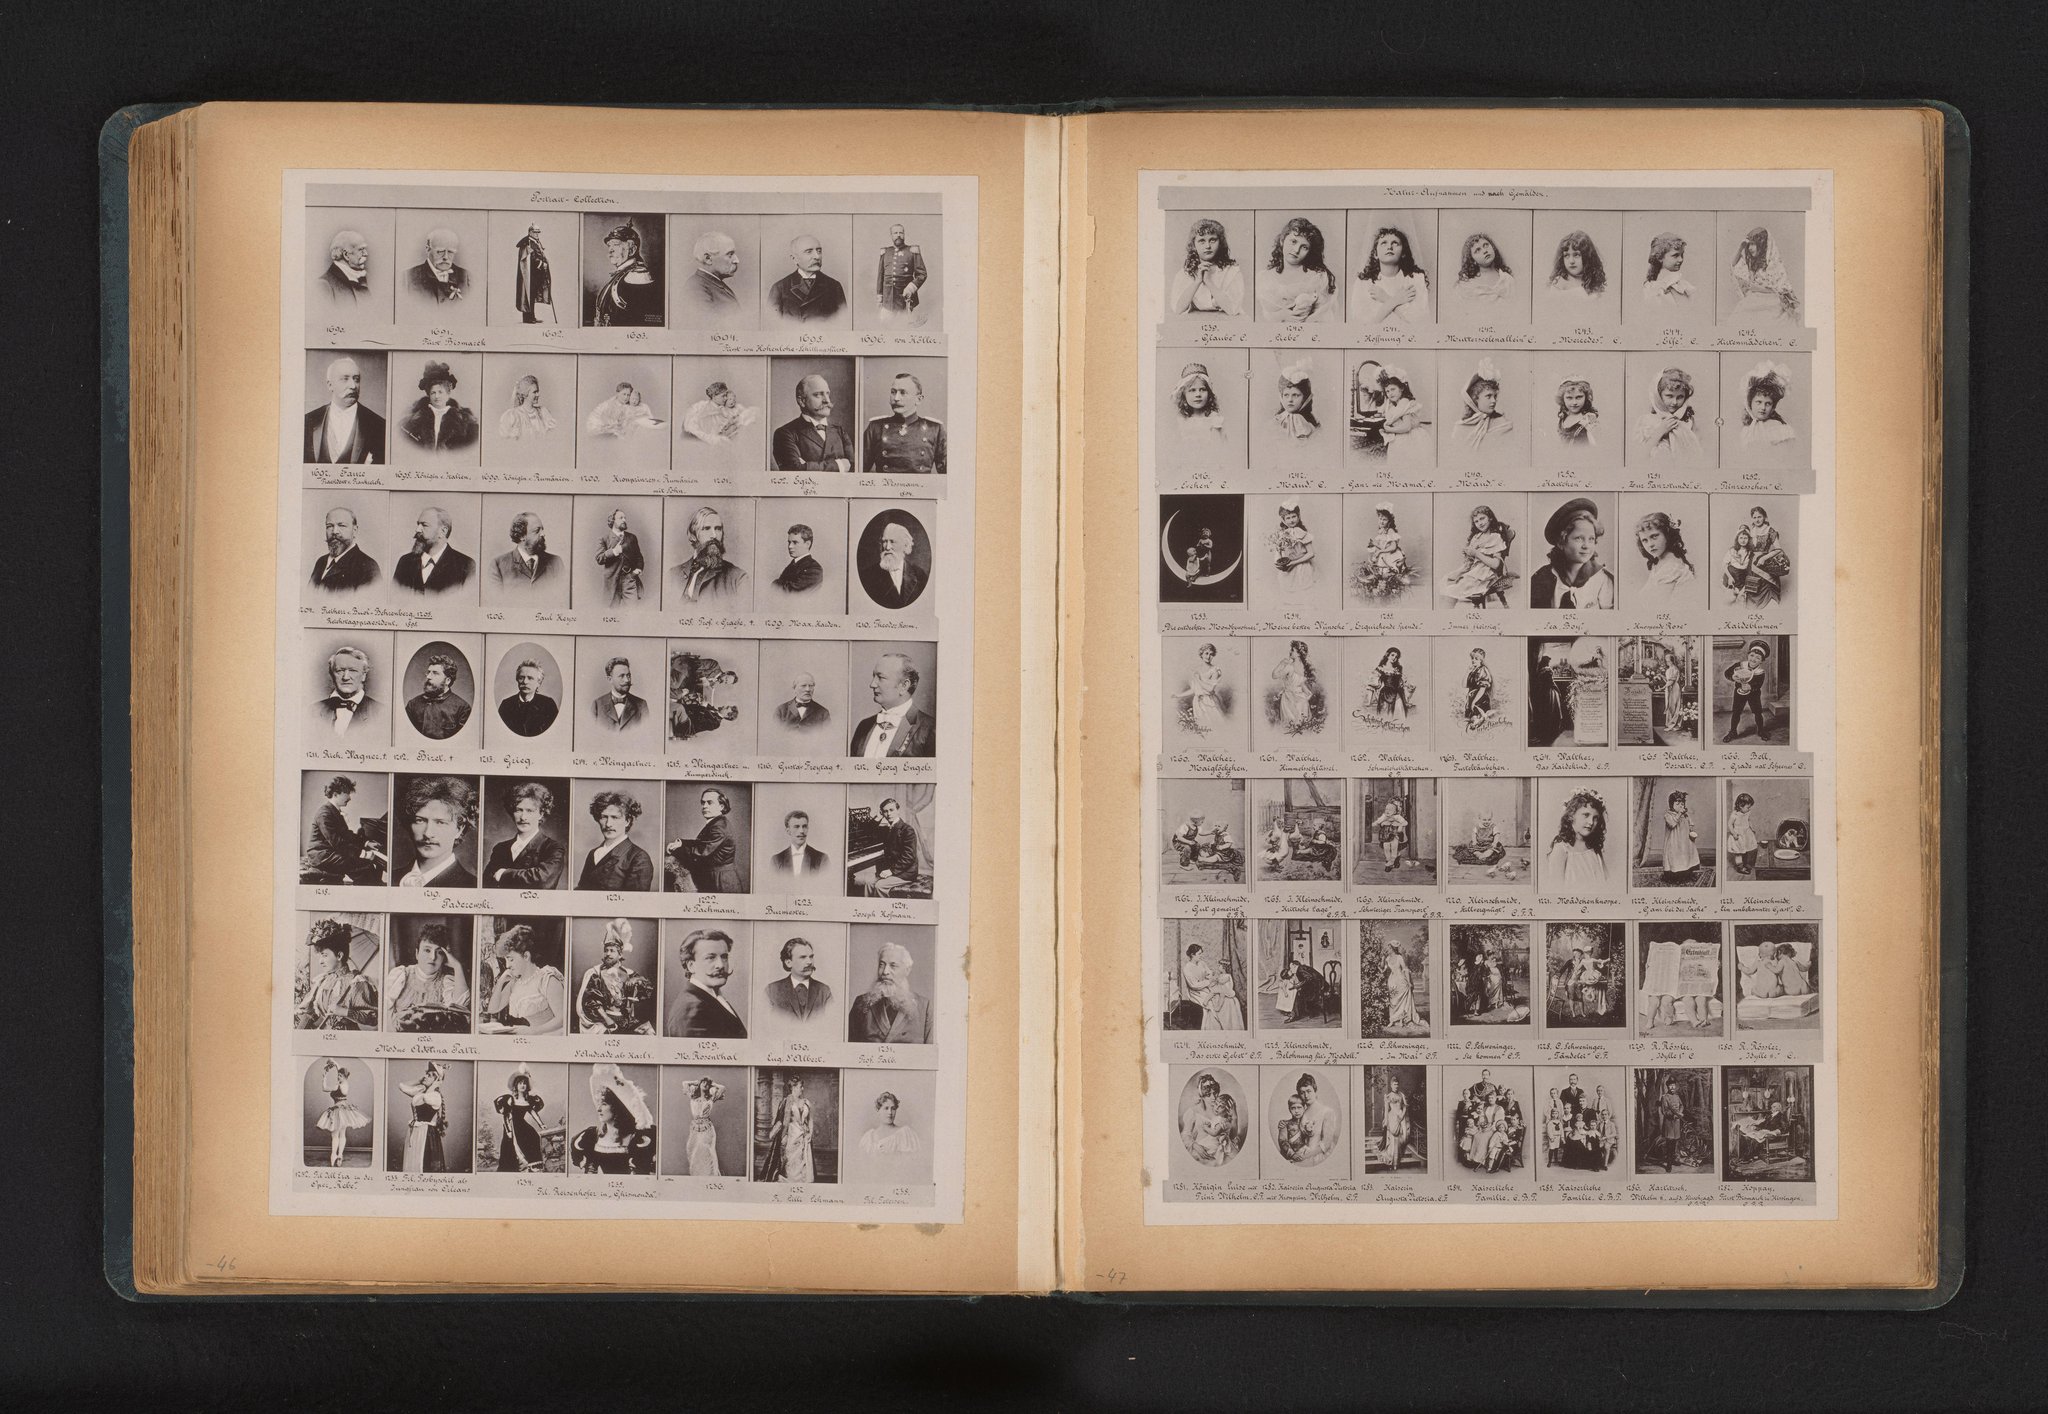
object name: photomechanical print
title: Portretten van politici, componisten en theatermakers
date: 1880-1885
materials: paper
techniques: photograph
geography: berlin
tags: historical persons (portraits and scenes from the life) - bb - woman, historical persons (portraits and scenes from the life)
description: Prent op zesenveertigste ongenummerde pagina.